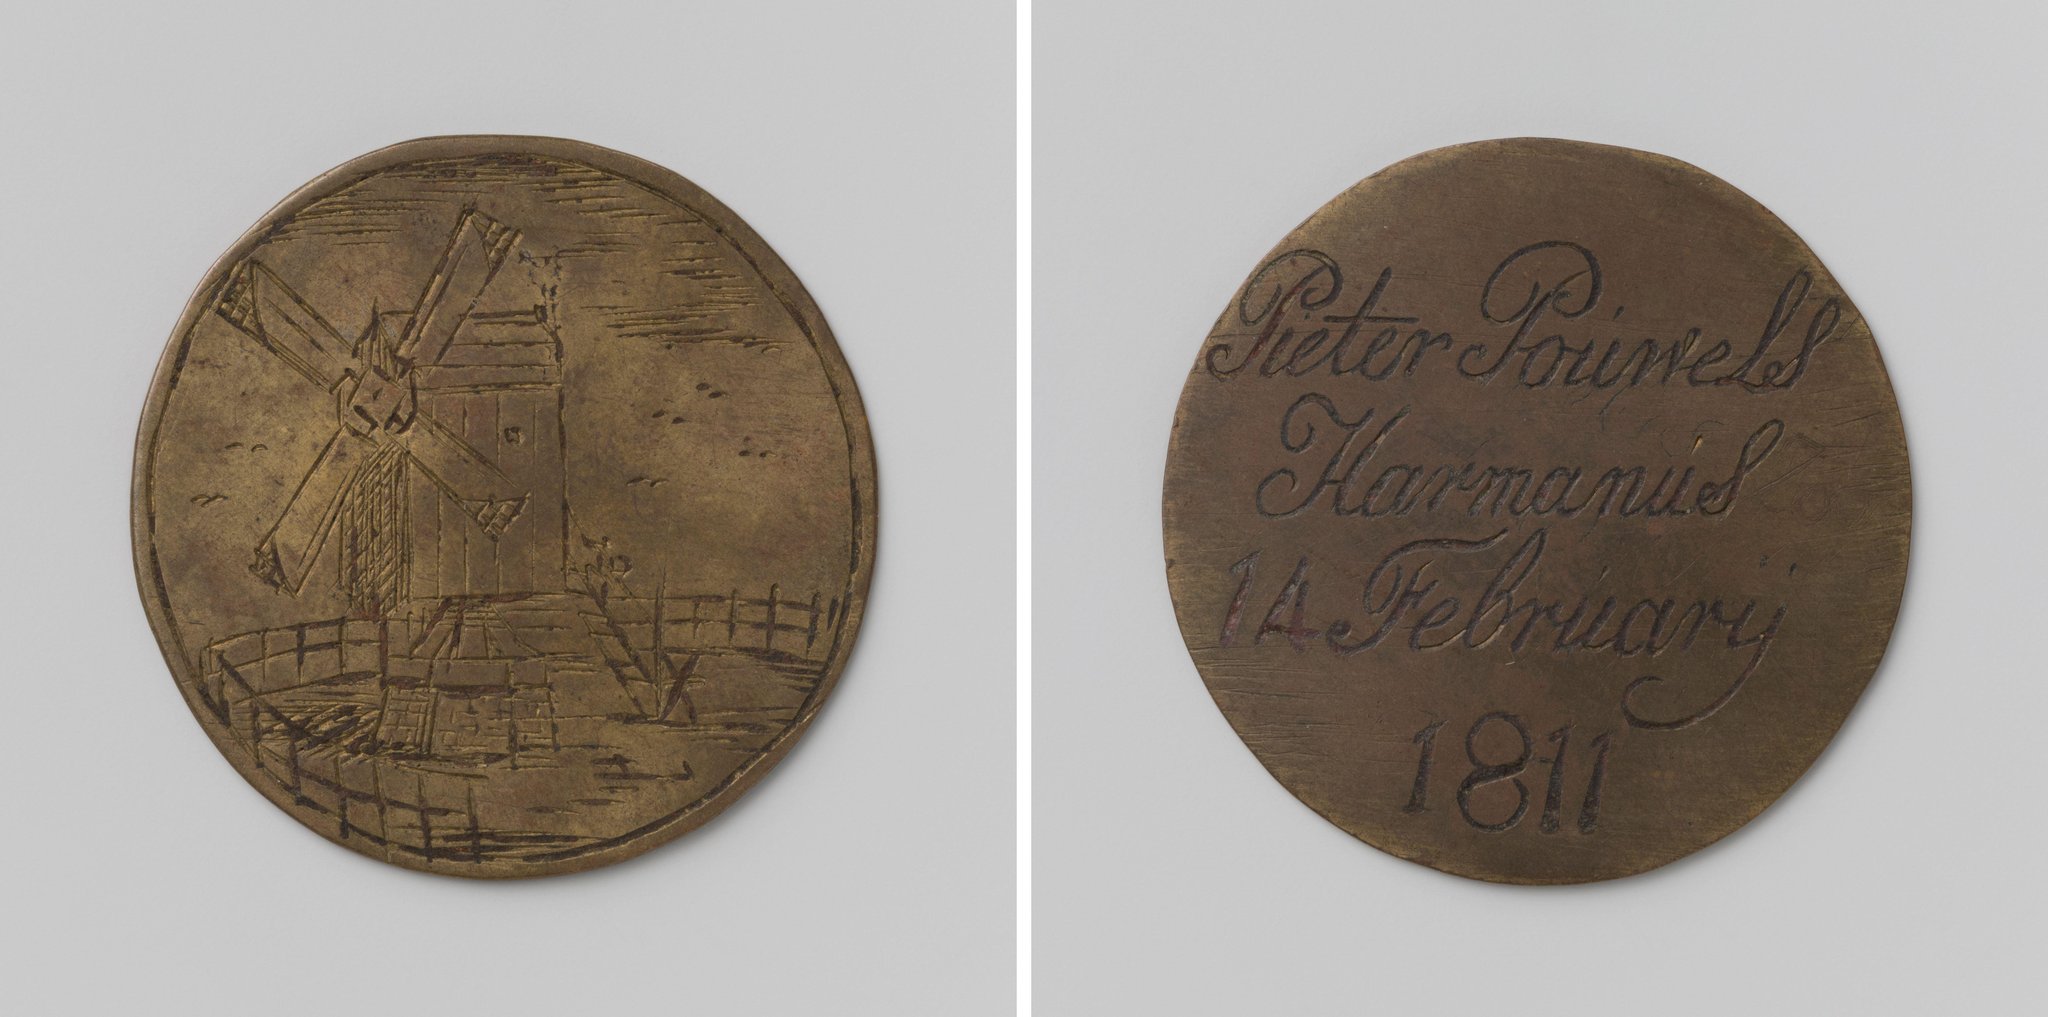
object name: medal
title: Korenmolenaarsgilde van Amsterdam, gildepenning van Pieter Pouwels Harmanus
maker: Anonymous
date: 1811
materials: brass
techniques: engraving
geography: amsterdam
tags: amsterdam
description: Messing penning. Voorzijde: korenmolen binnen omheining. Keerzijde: opschrift